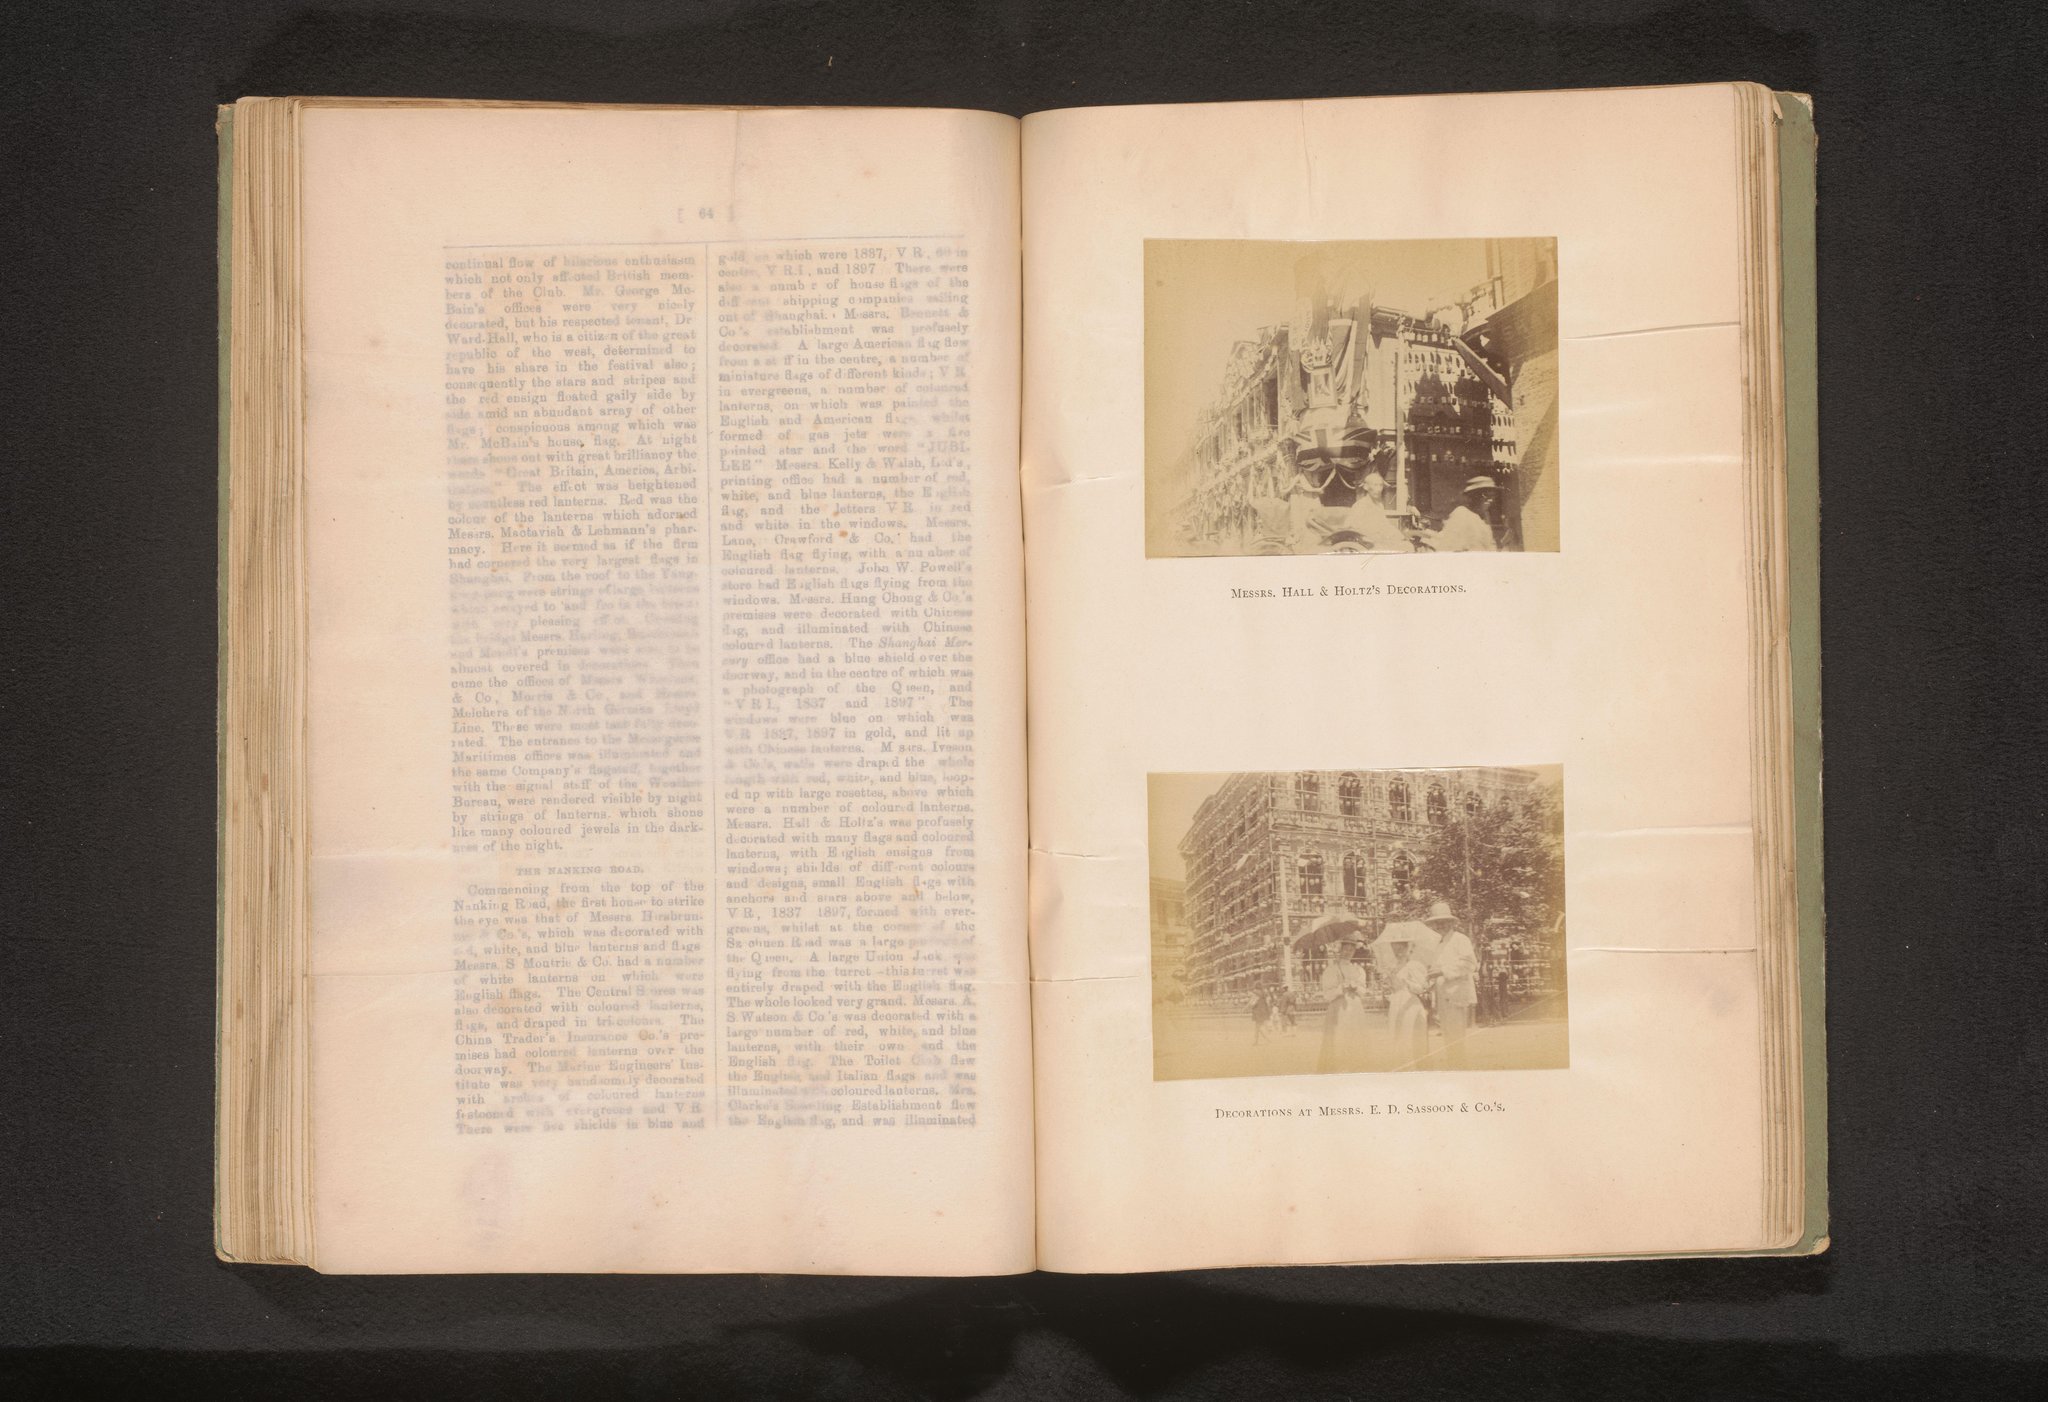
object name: photograph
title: Messrs. Hall & Holtz's decorations. Decorations at Messrs. E.D. Sassoon & Co.'s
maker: w.r. kahler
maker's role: fotograaf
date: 1897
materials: photographic support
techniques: albumen print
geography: shanghai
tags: festivities (+ wreath, garland ~ festive activities), façade (of house or building), commemoration, jubilee, street